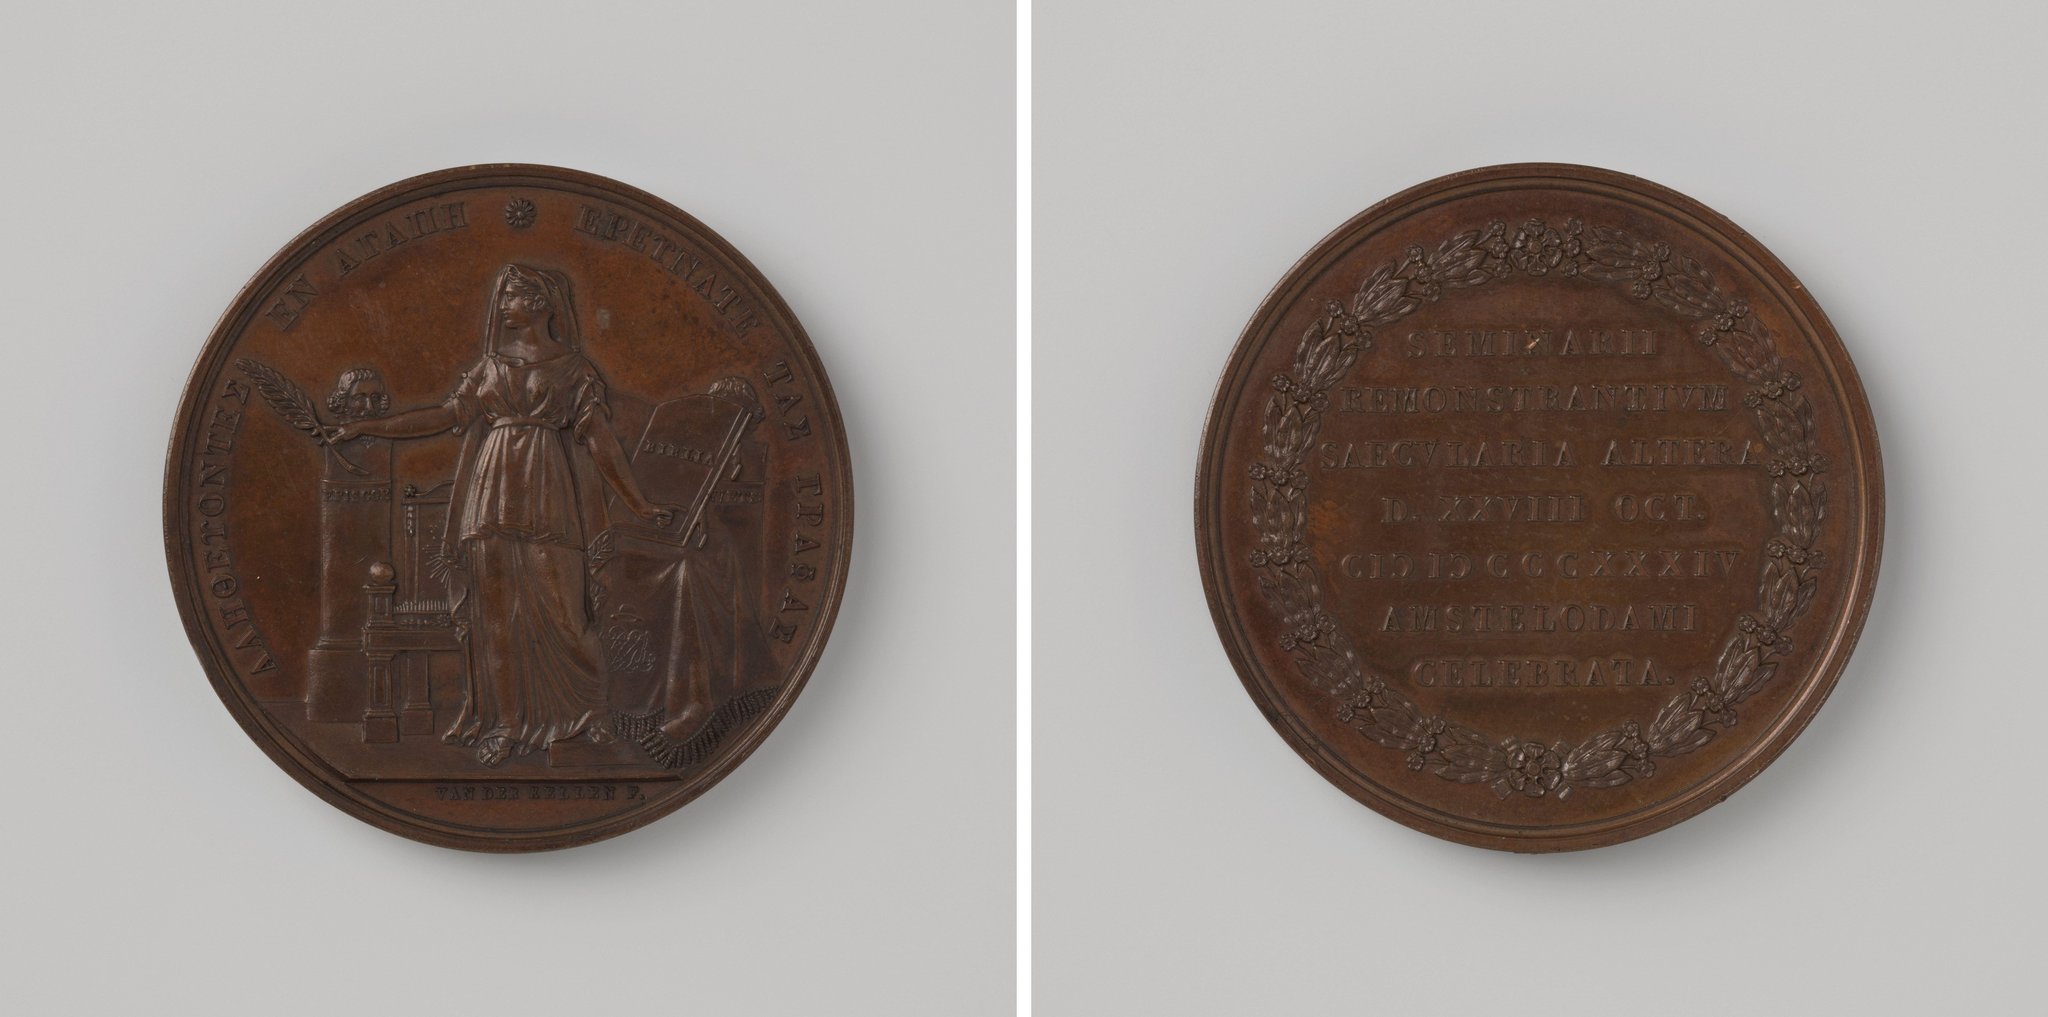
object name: history medal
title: Tweehonderdjarig bestaan van het Remonstrants Seminarium te Amsterdam 1834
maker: david van der kellen (1804-1879)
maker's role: die cutter, draughtsman, print maker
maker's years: 1804-1879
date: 1834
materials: bronze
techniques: striking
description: Bronzen penning, op de voorzijde naast een troon een gesluierde vrouw met palmtak, wijzend op de bijbel op een tafel, tussen zuilen waarop de borstbeelden van Episcopius en Wetstein, met omschrift, op de keerzijde zeven regels tekst binnen een mirtenkrans.